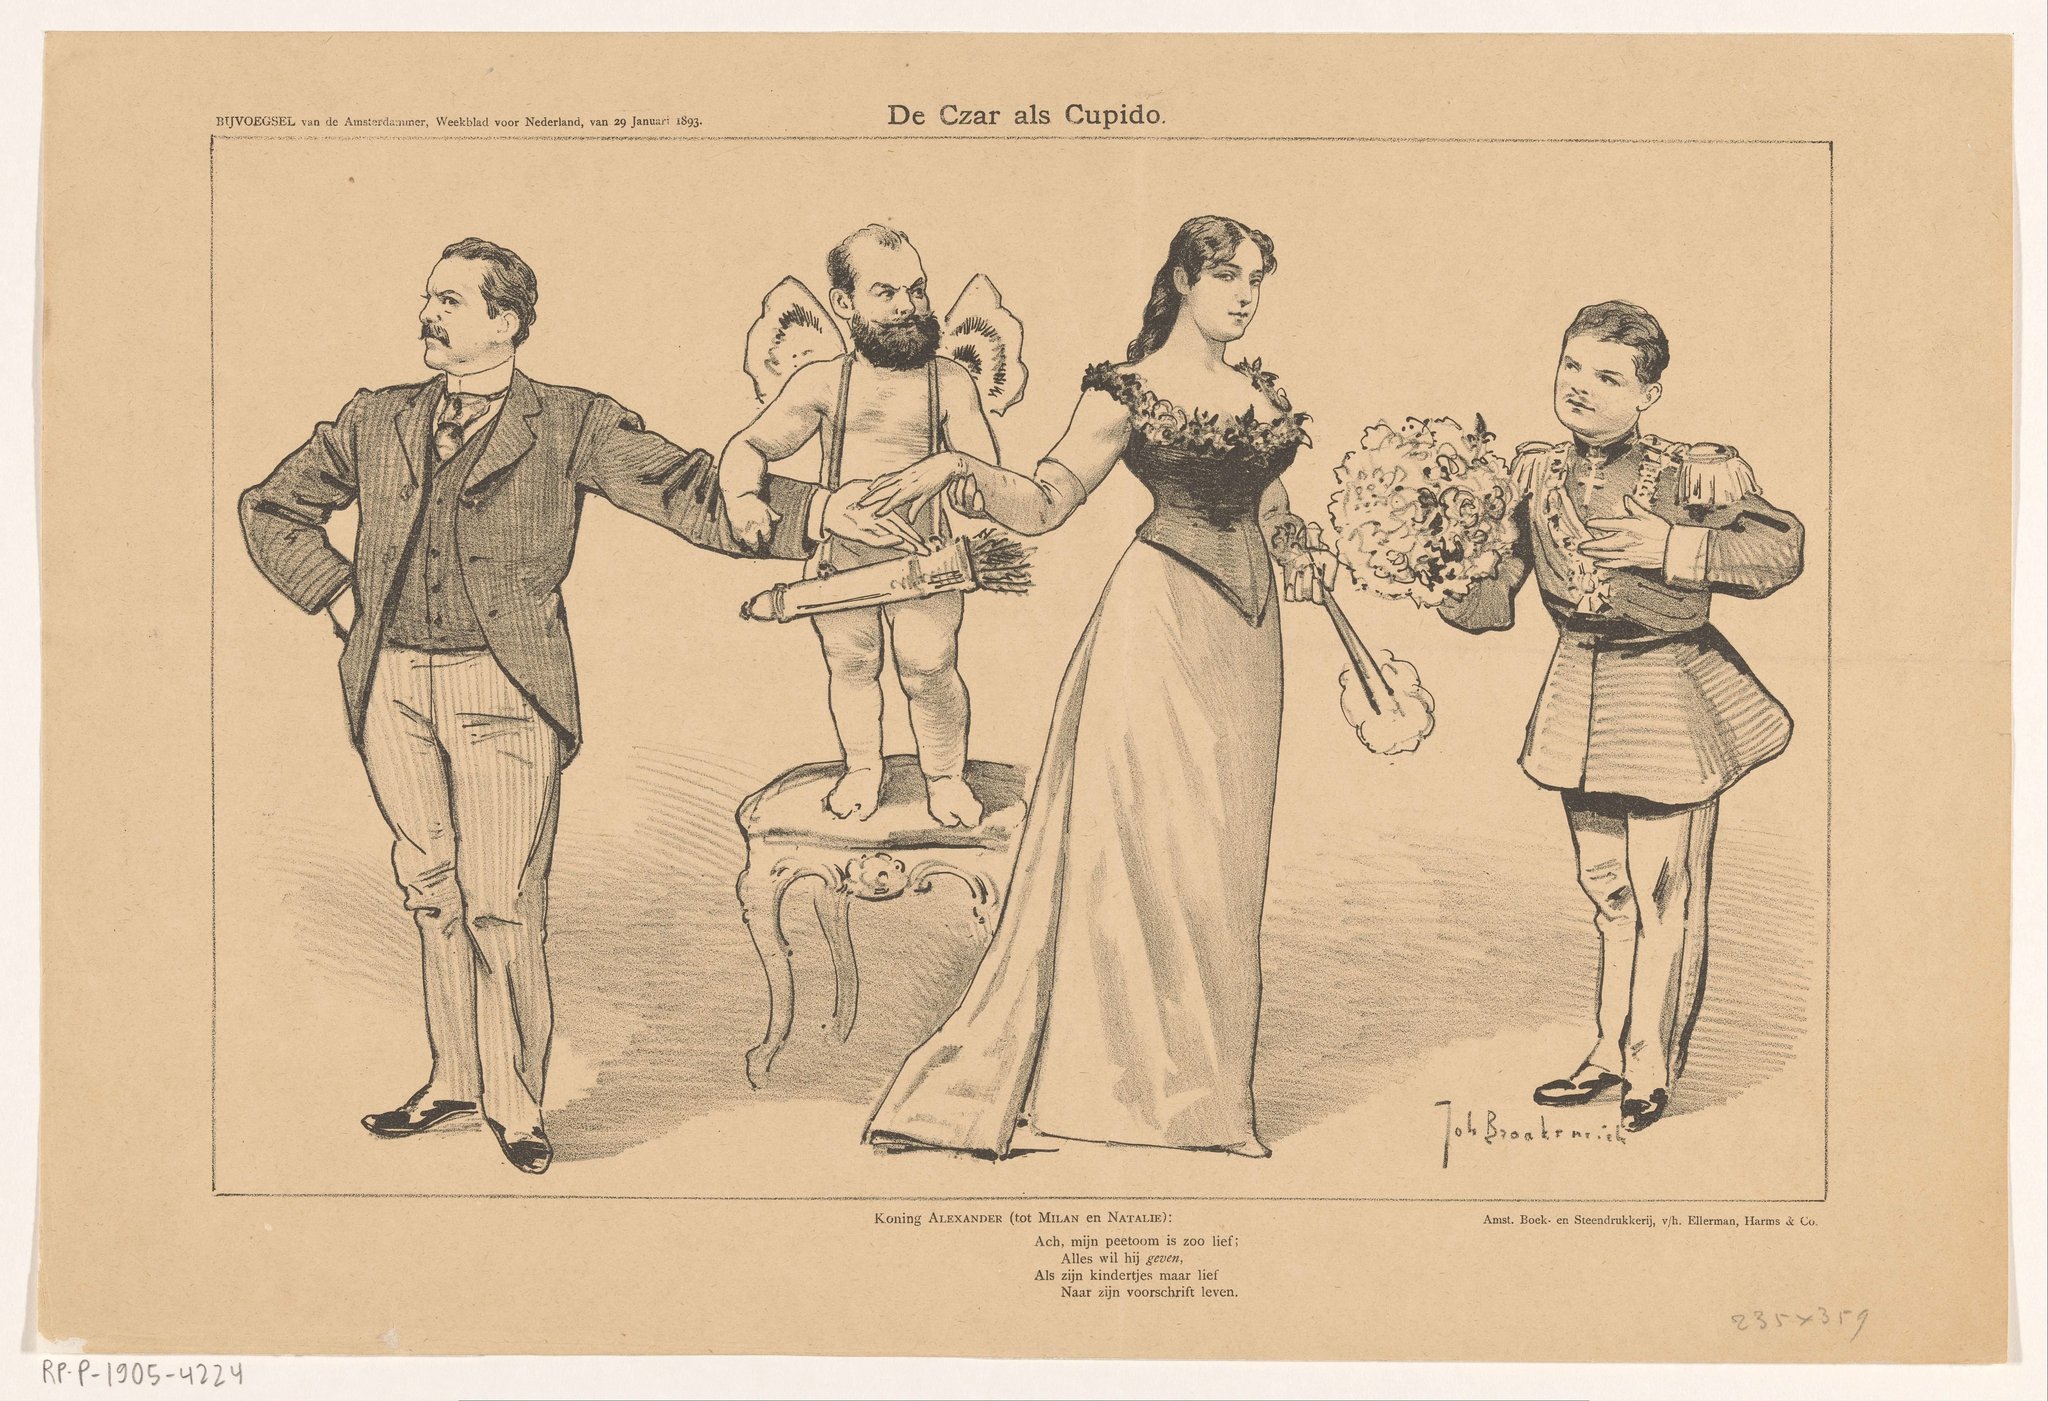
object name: cartoon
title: De czar als Cupido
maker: johan braakensiek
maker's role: draughtsman, print maker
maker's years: 1858-1940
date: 1893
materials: paper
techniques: lithograph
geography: amsterdam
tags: (story of) cupid, amor (eros), ranks ~ rulers, sovereigns, political caricatures and satires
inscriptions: collector's mark: Lugt 2228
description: De Russische tsaar Alexander III verzoent Milan I van Servië en Natalie van Servië met elkaar. Rechts koning Alexander I die zijn moeder een boeket aanreikt.